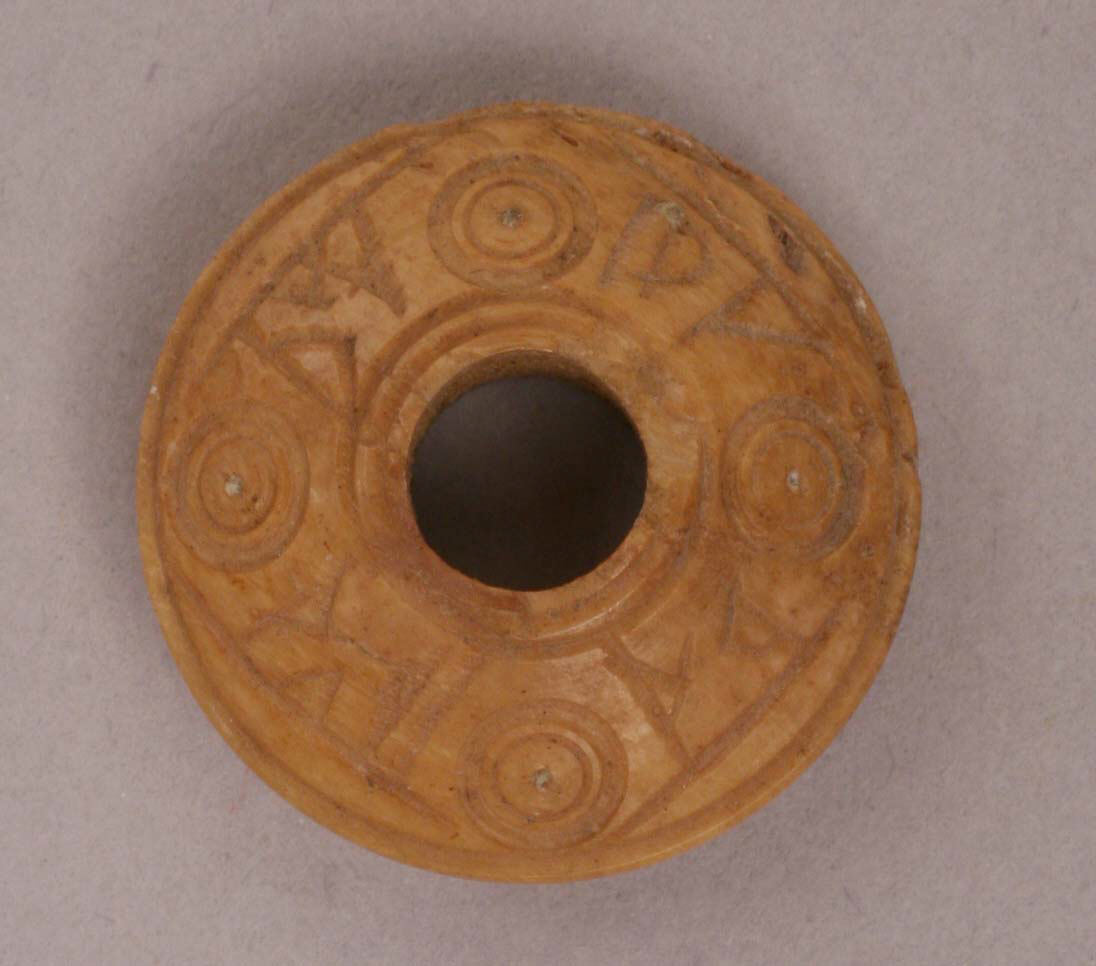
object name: button or bead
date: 801-1000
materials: bone, paint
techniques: incising, inlay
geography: iran